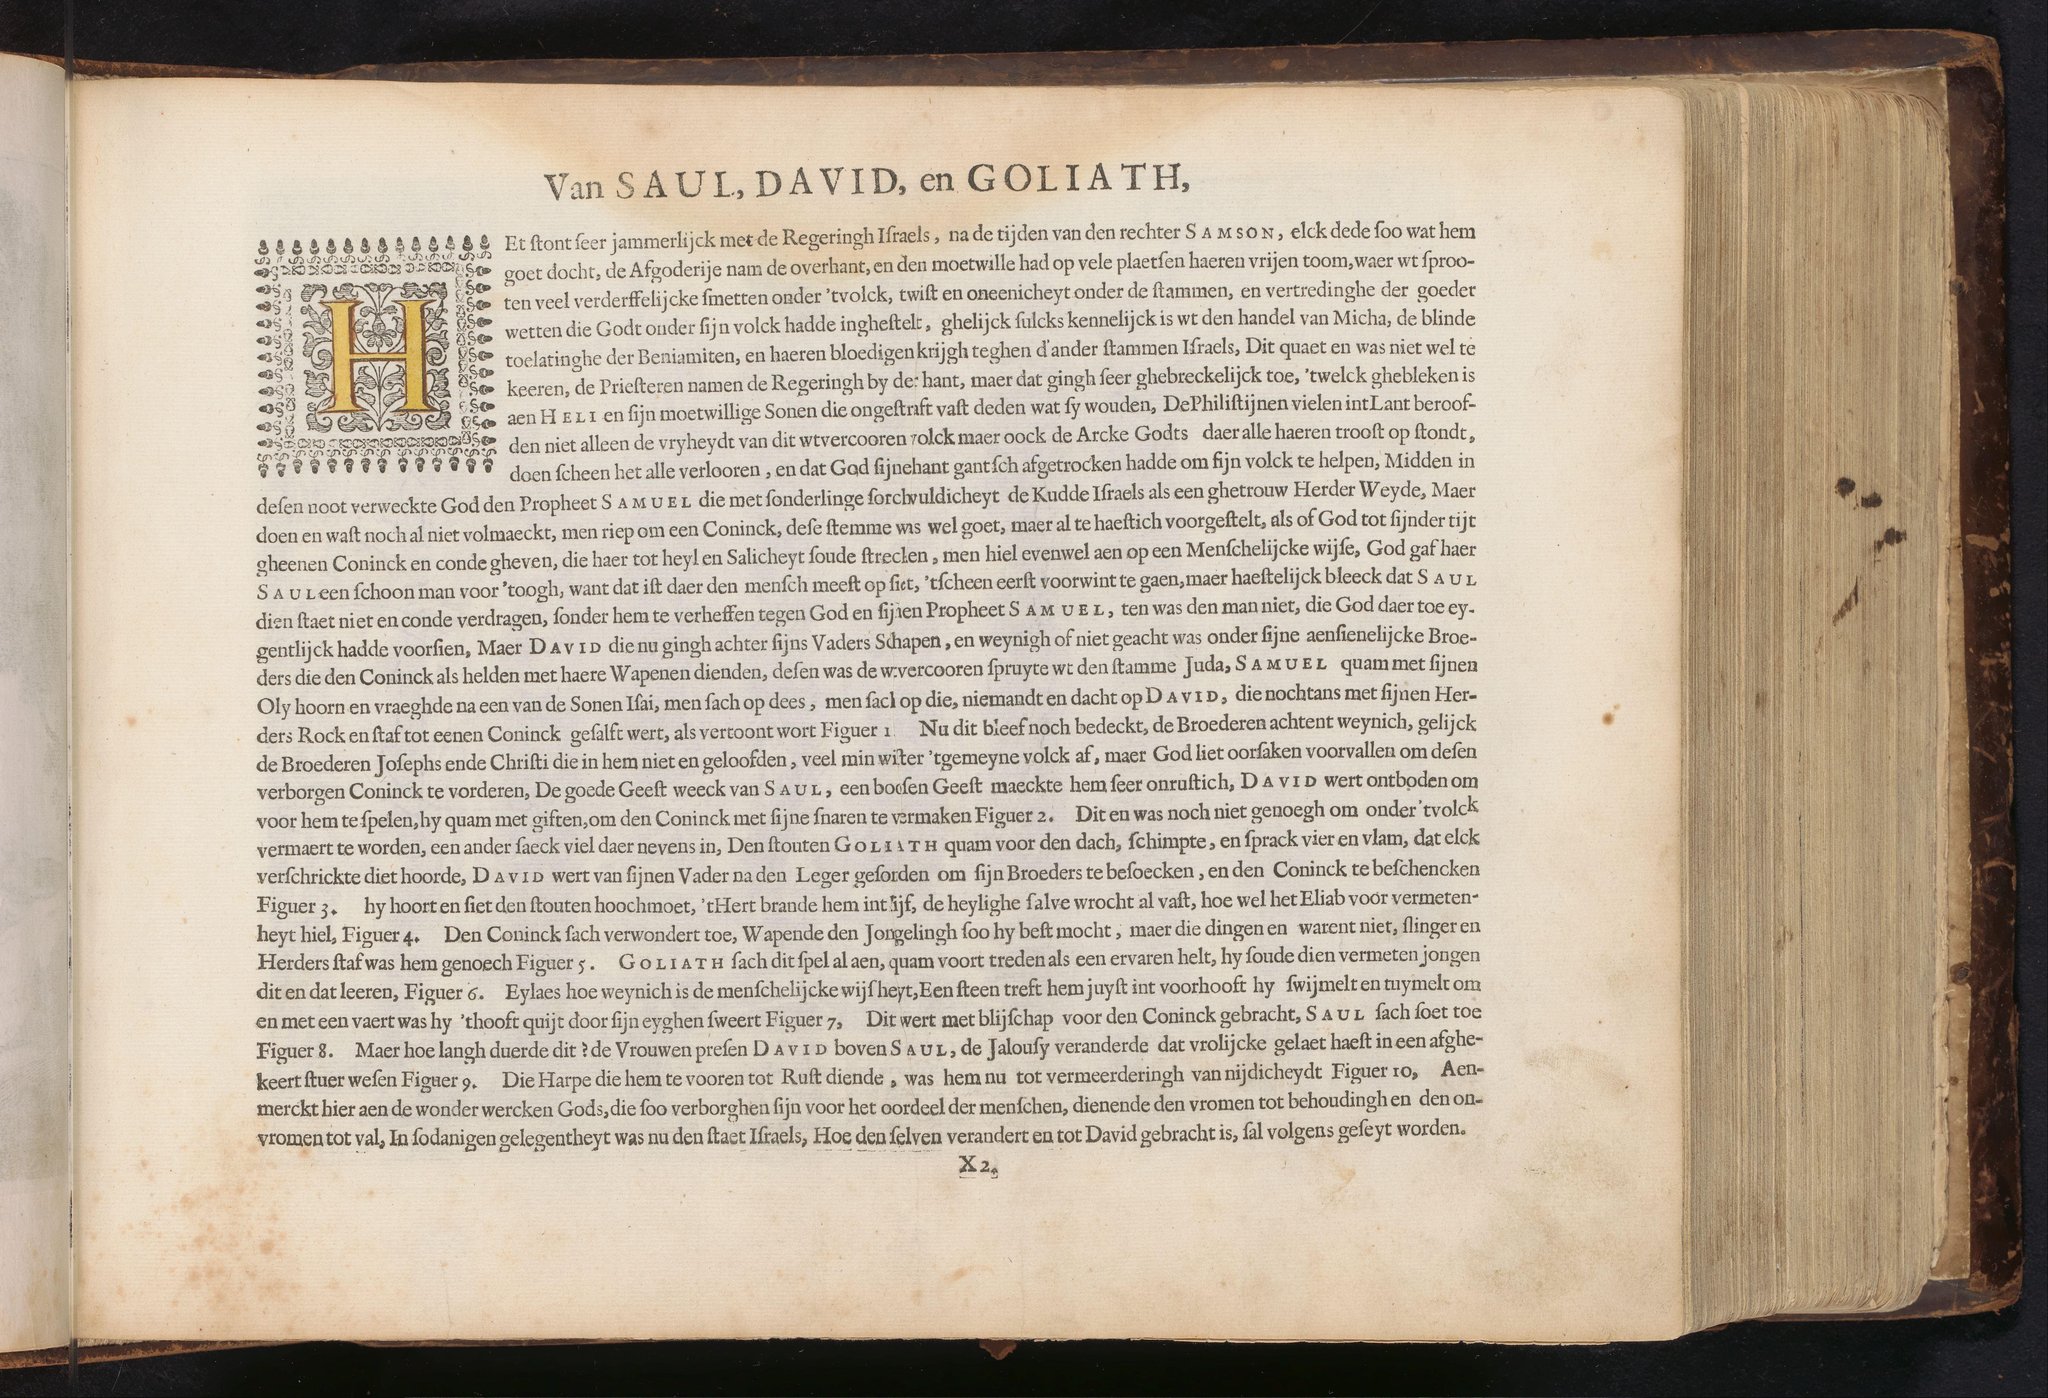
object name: text sheet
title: Van Saul, David, en Goliath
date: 1646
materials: paper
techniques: hand coloring, letterpress printing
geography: alkmaar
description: Tekstblad bij een serie prenten over de geschiedenis van David en Saul. Linksboven initiaal H. Dit blad maakt deel uit van een album.